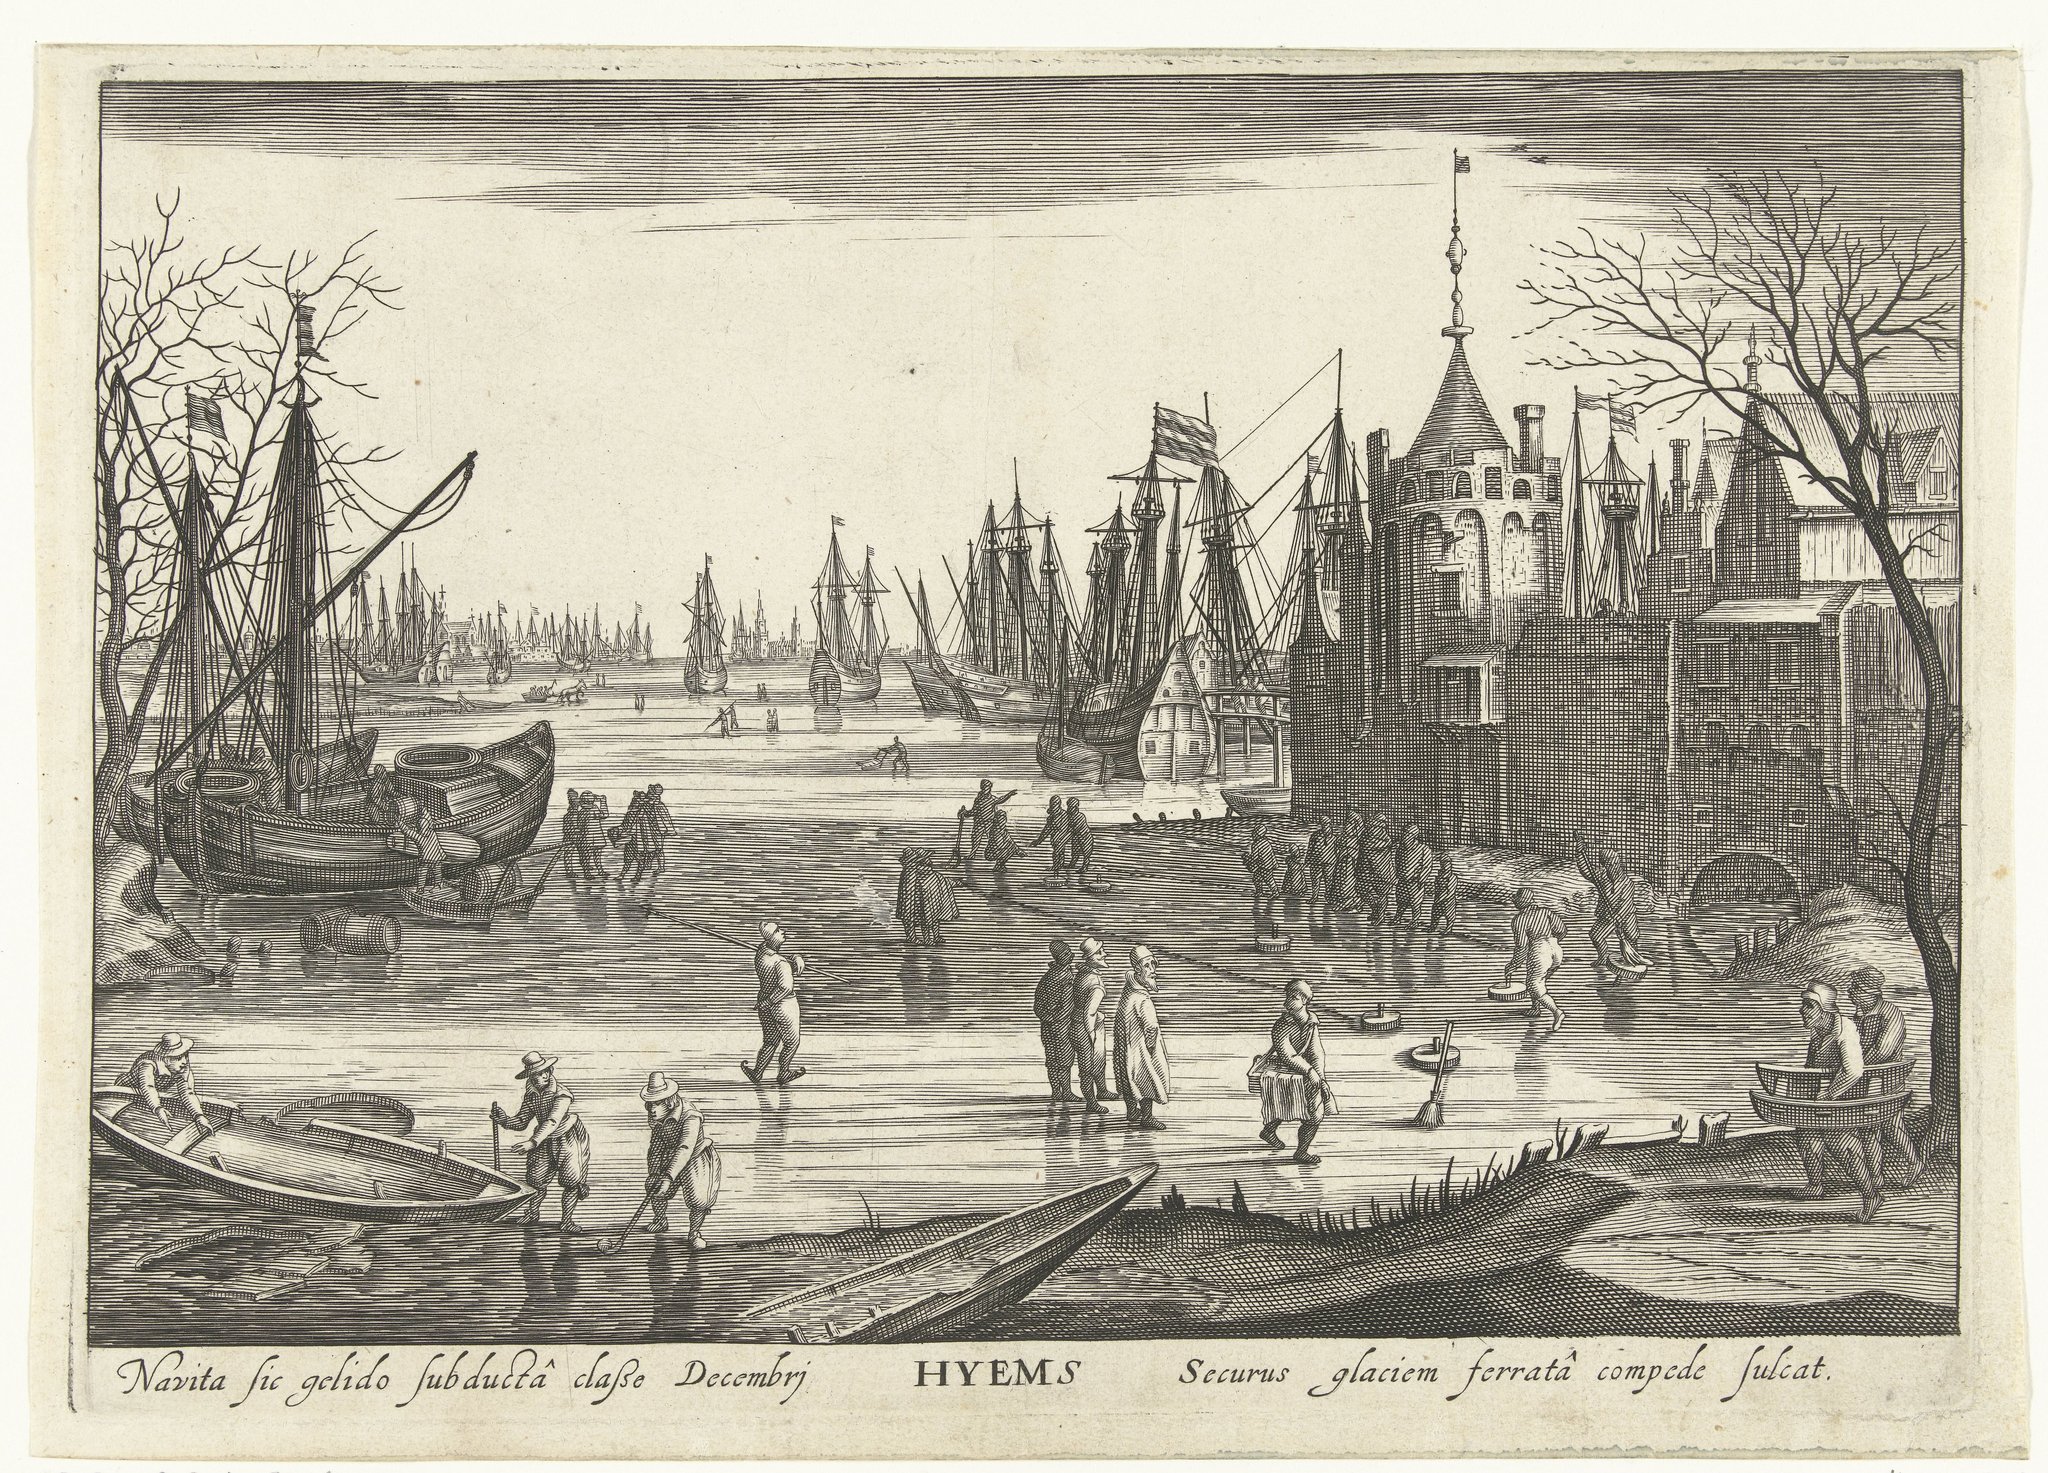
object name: print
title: Hyems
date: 1618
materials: paper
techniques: engraving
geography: amsterdam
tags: winter ~ human activities (the four seasons of the year), winter landscape; landscape symbolizing winter (the four seasons of the year), skates (winter sports)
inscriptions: collector's mark: Lugt 2228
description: Schaatsers op het ijs. Op de achtergrond schepen in het ijs. Rechts de oever met de rand van een stadje. Met een onderschrift in het Latijn. Prent uit een serie met de vier seizoenen verbeeld als zeegezichten.